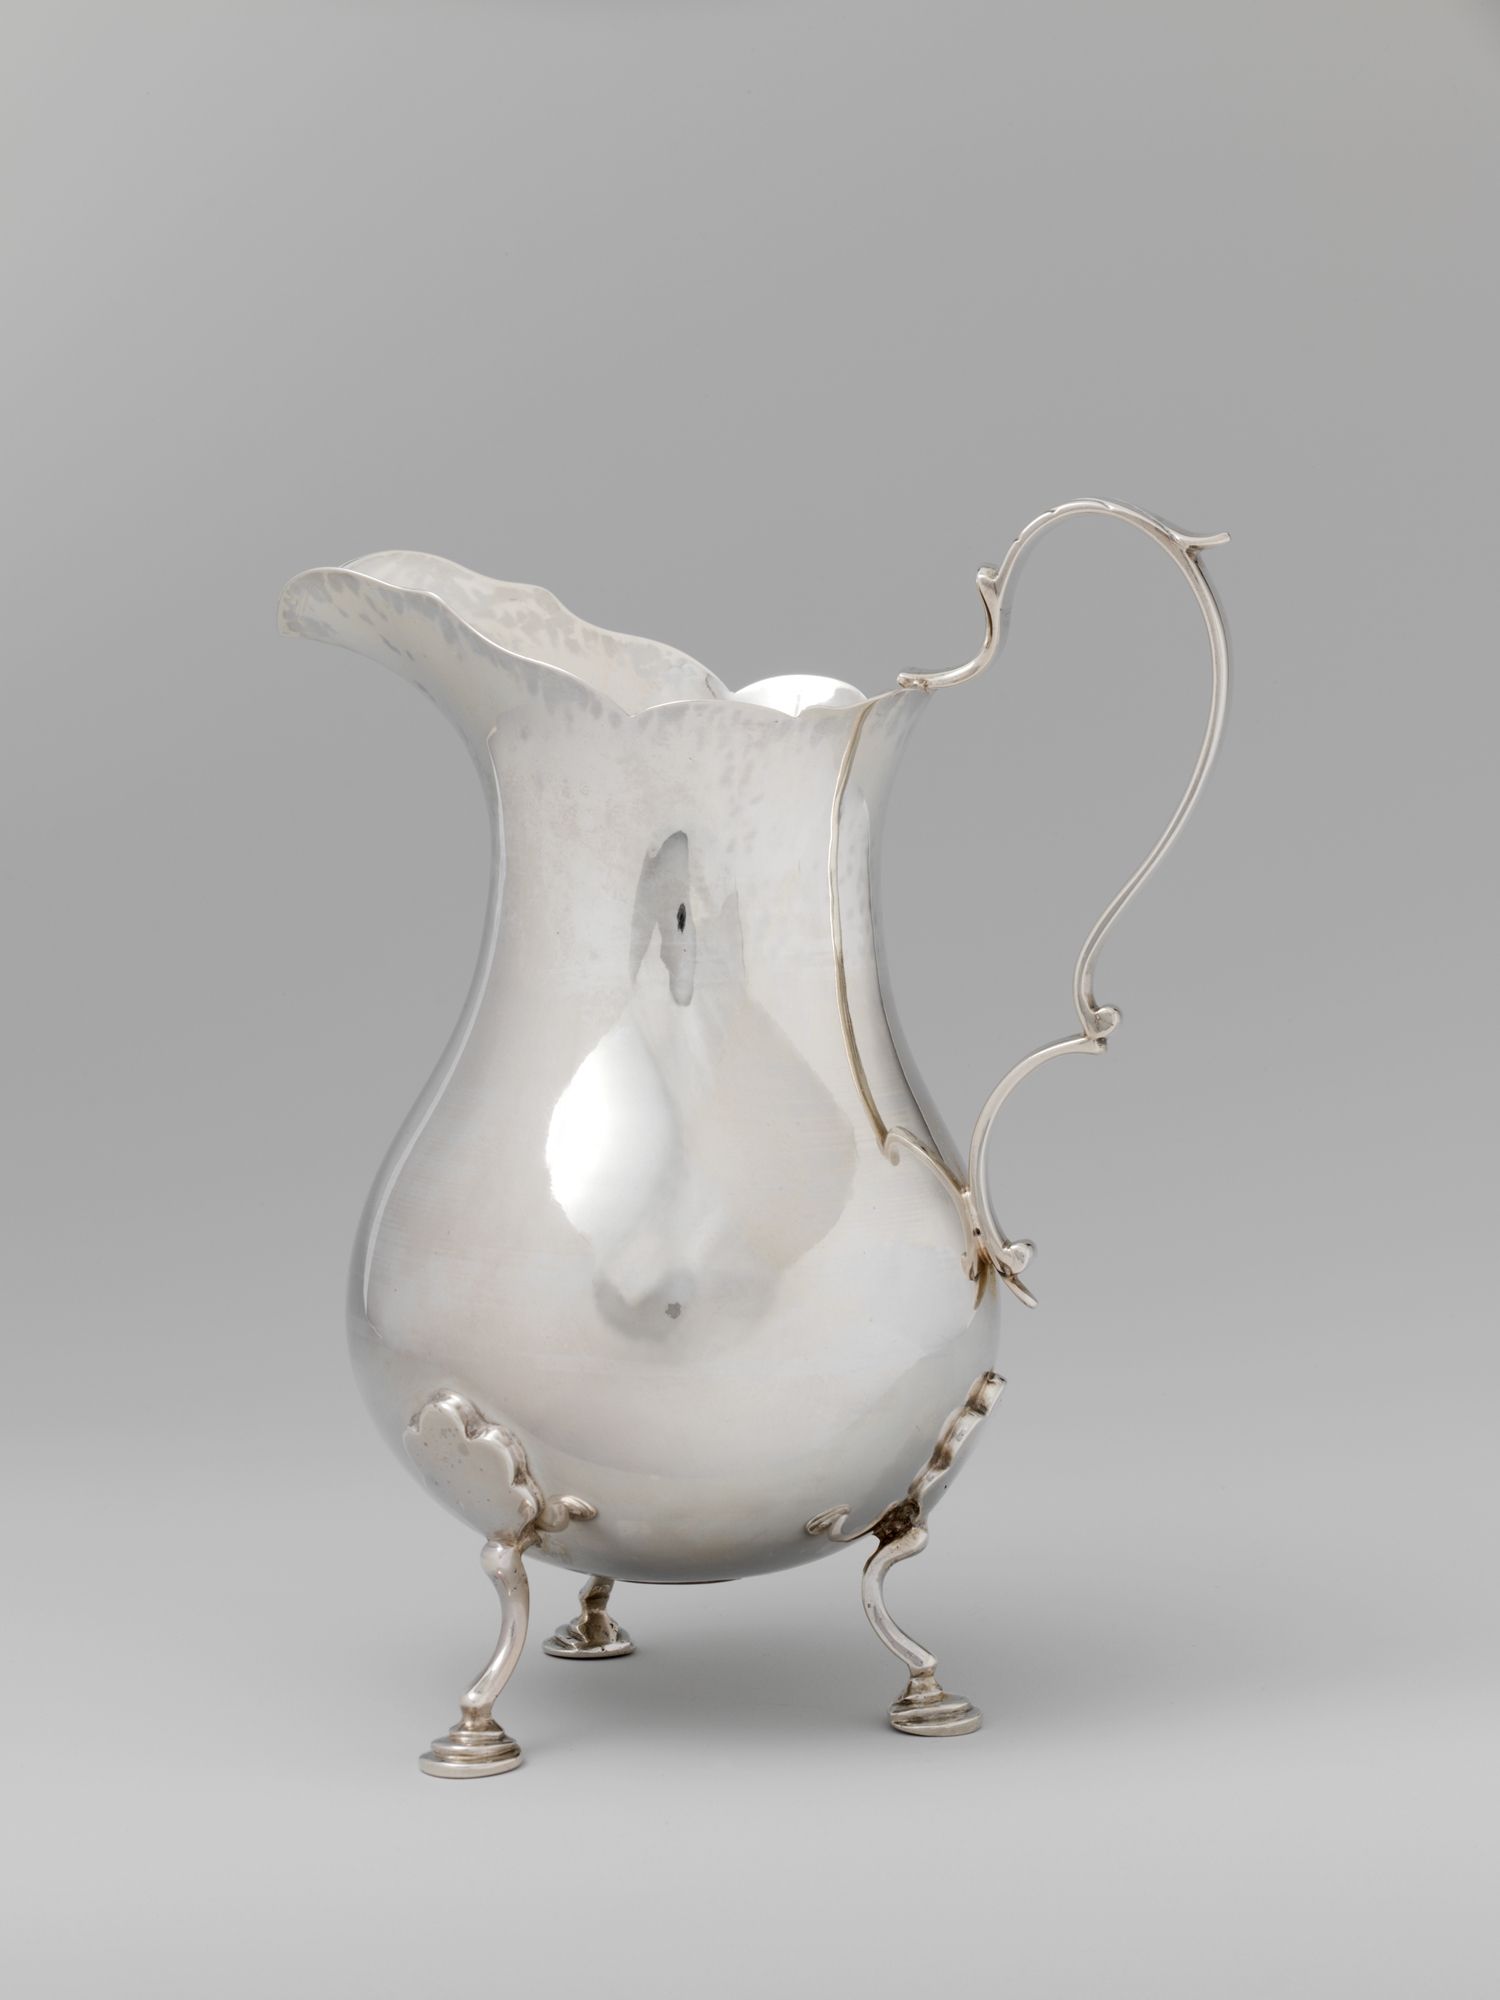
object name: cream pot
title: Creamer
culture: dutch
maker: philippus priee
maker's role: maker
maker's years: 1721-1793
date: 1760-1780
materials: silver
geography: netherlands